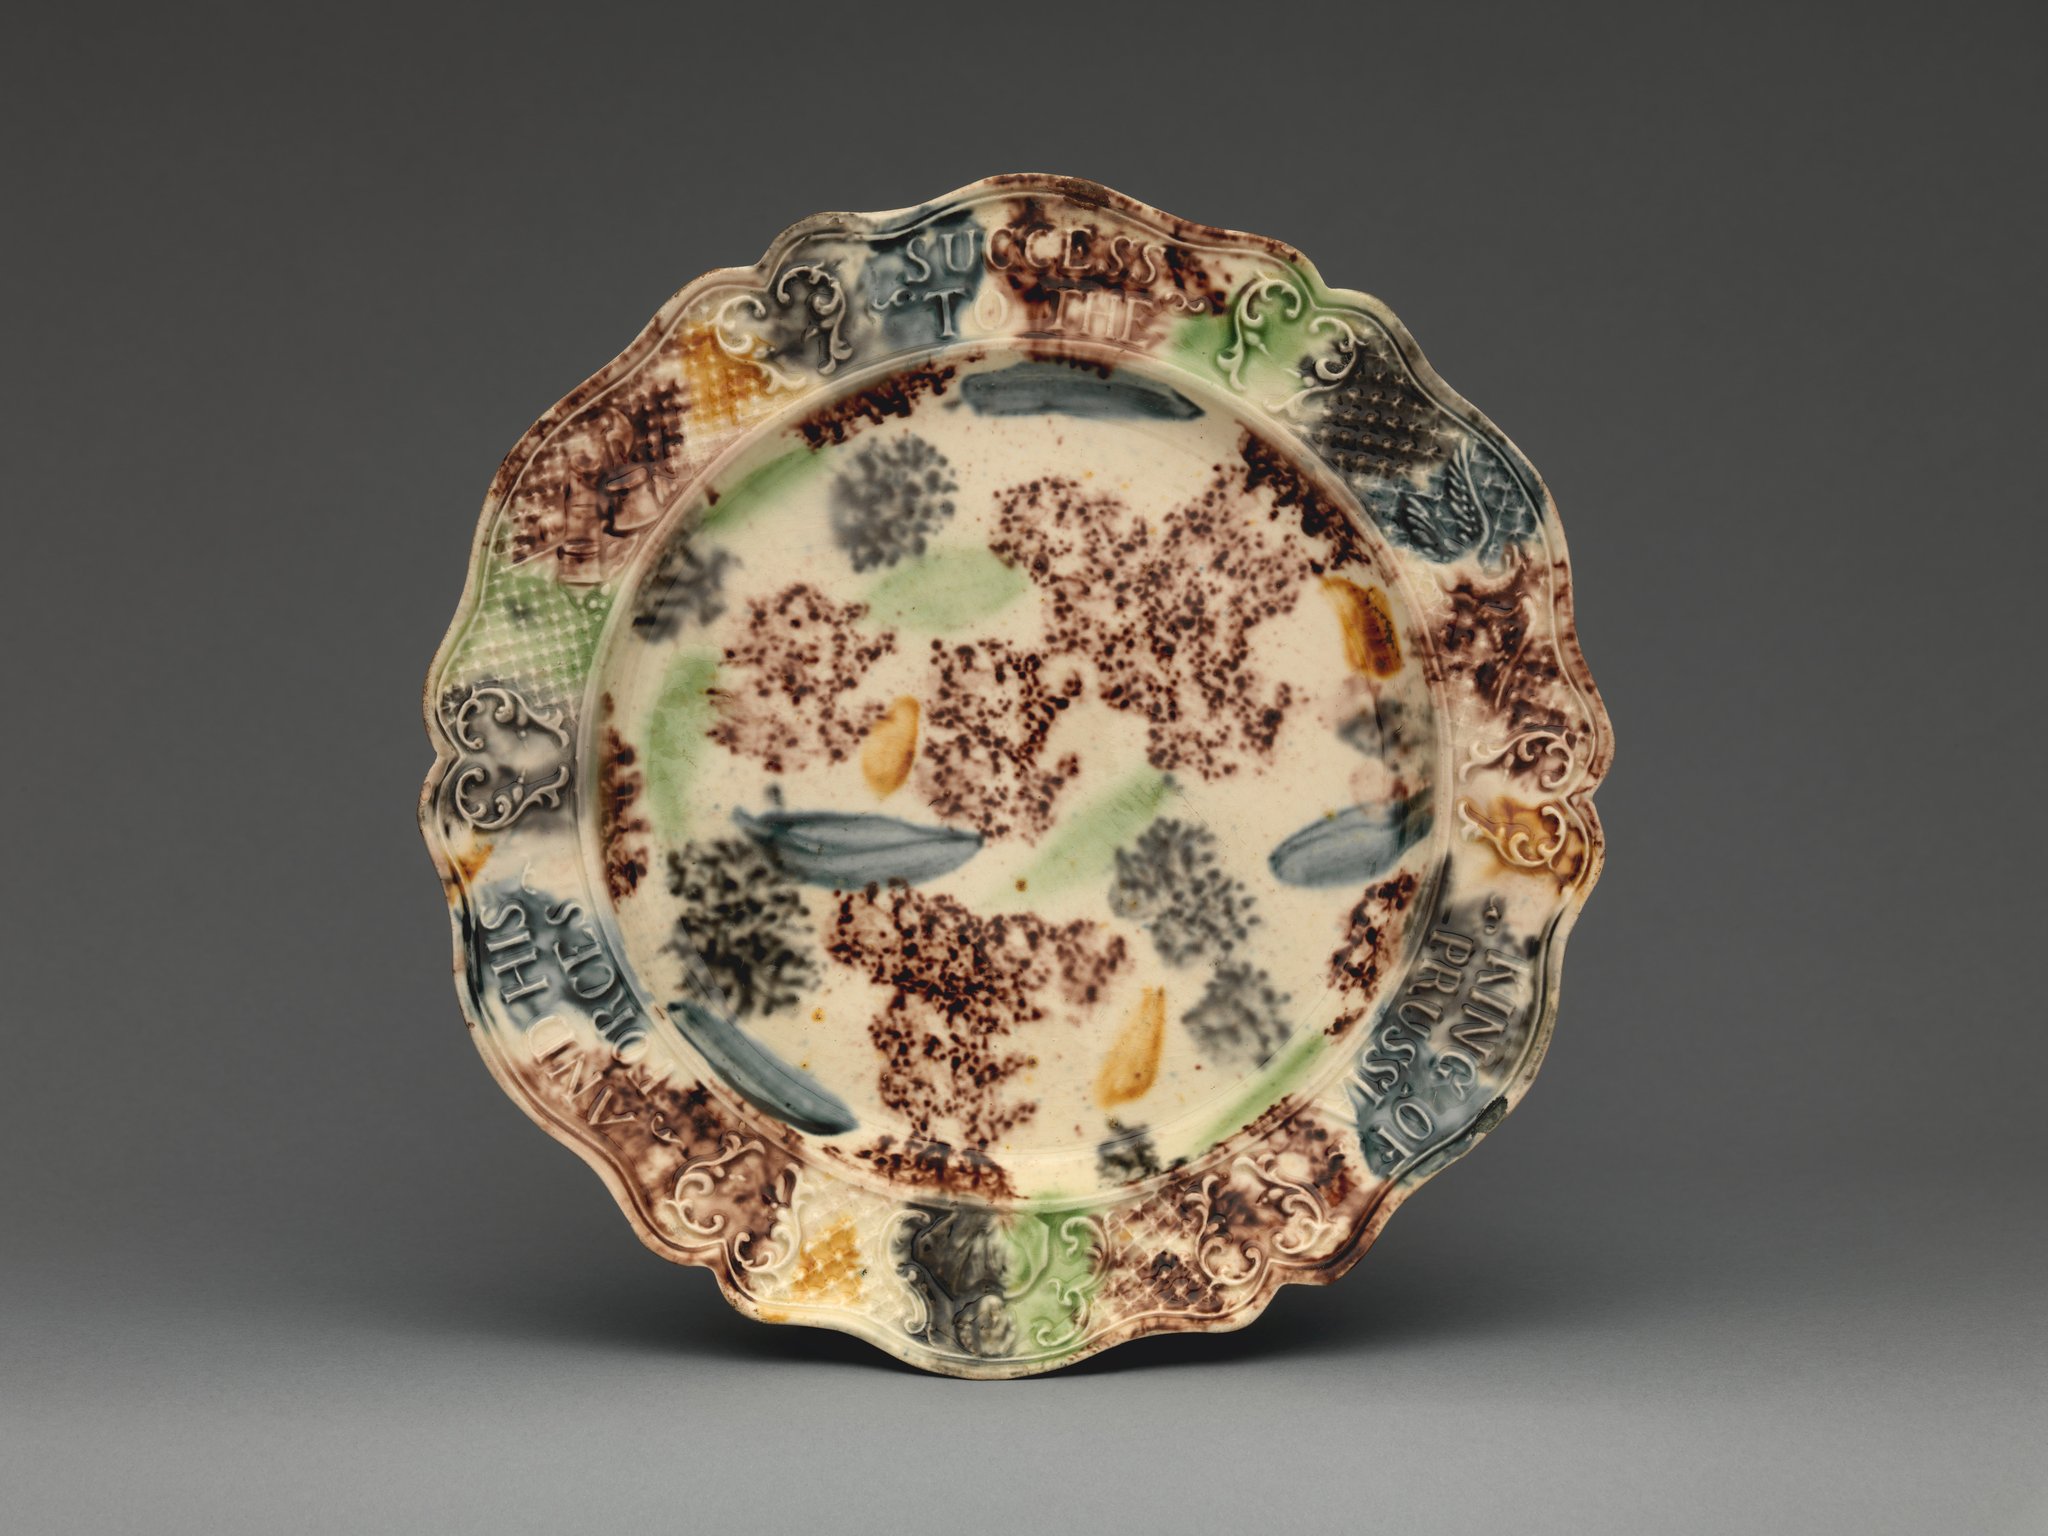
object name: dish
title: Dish with King of Prussia inscription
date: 1756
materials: earthenware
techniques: glazing